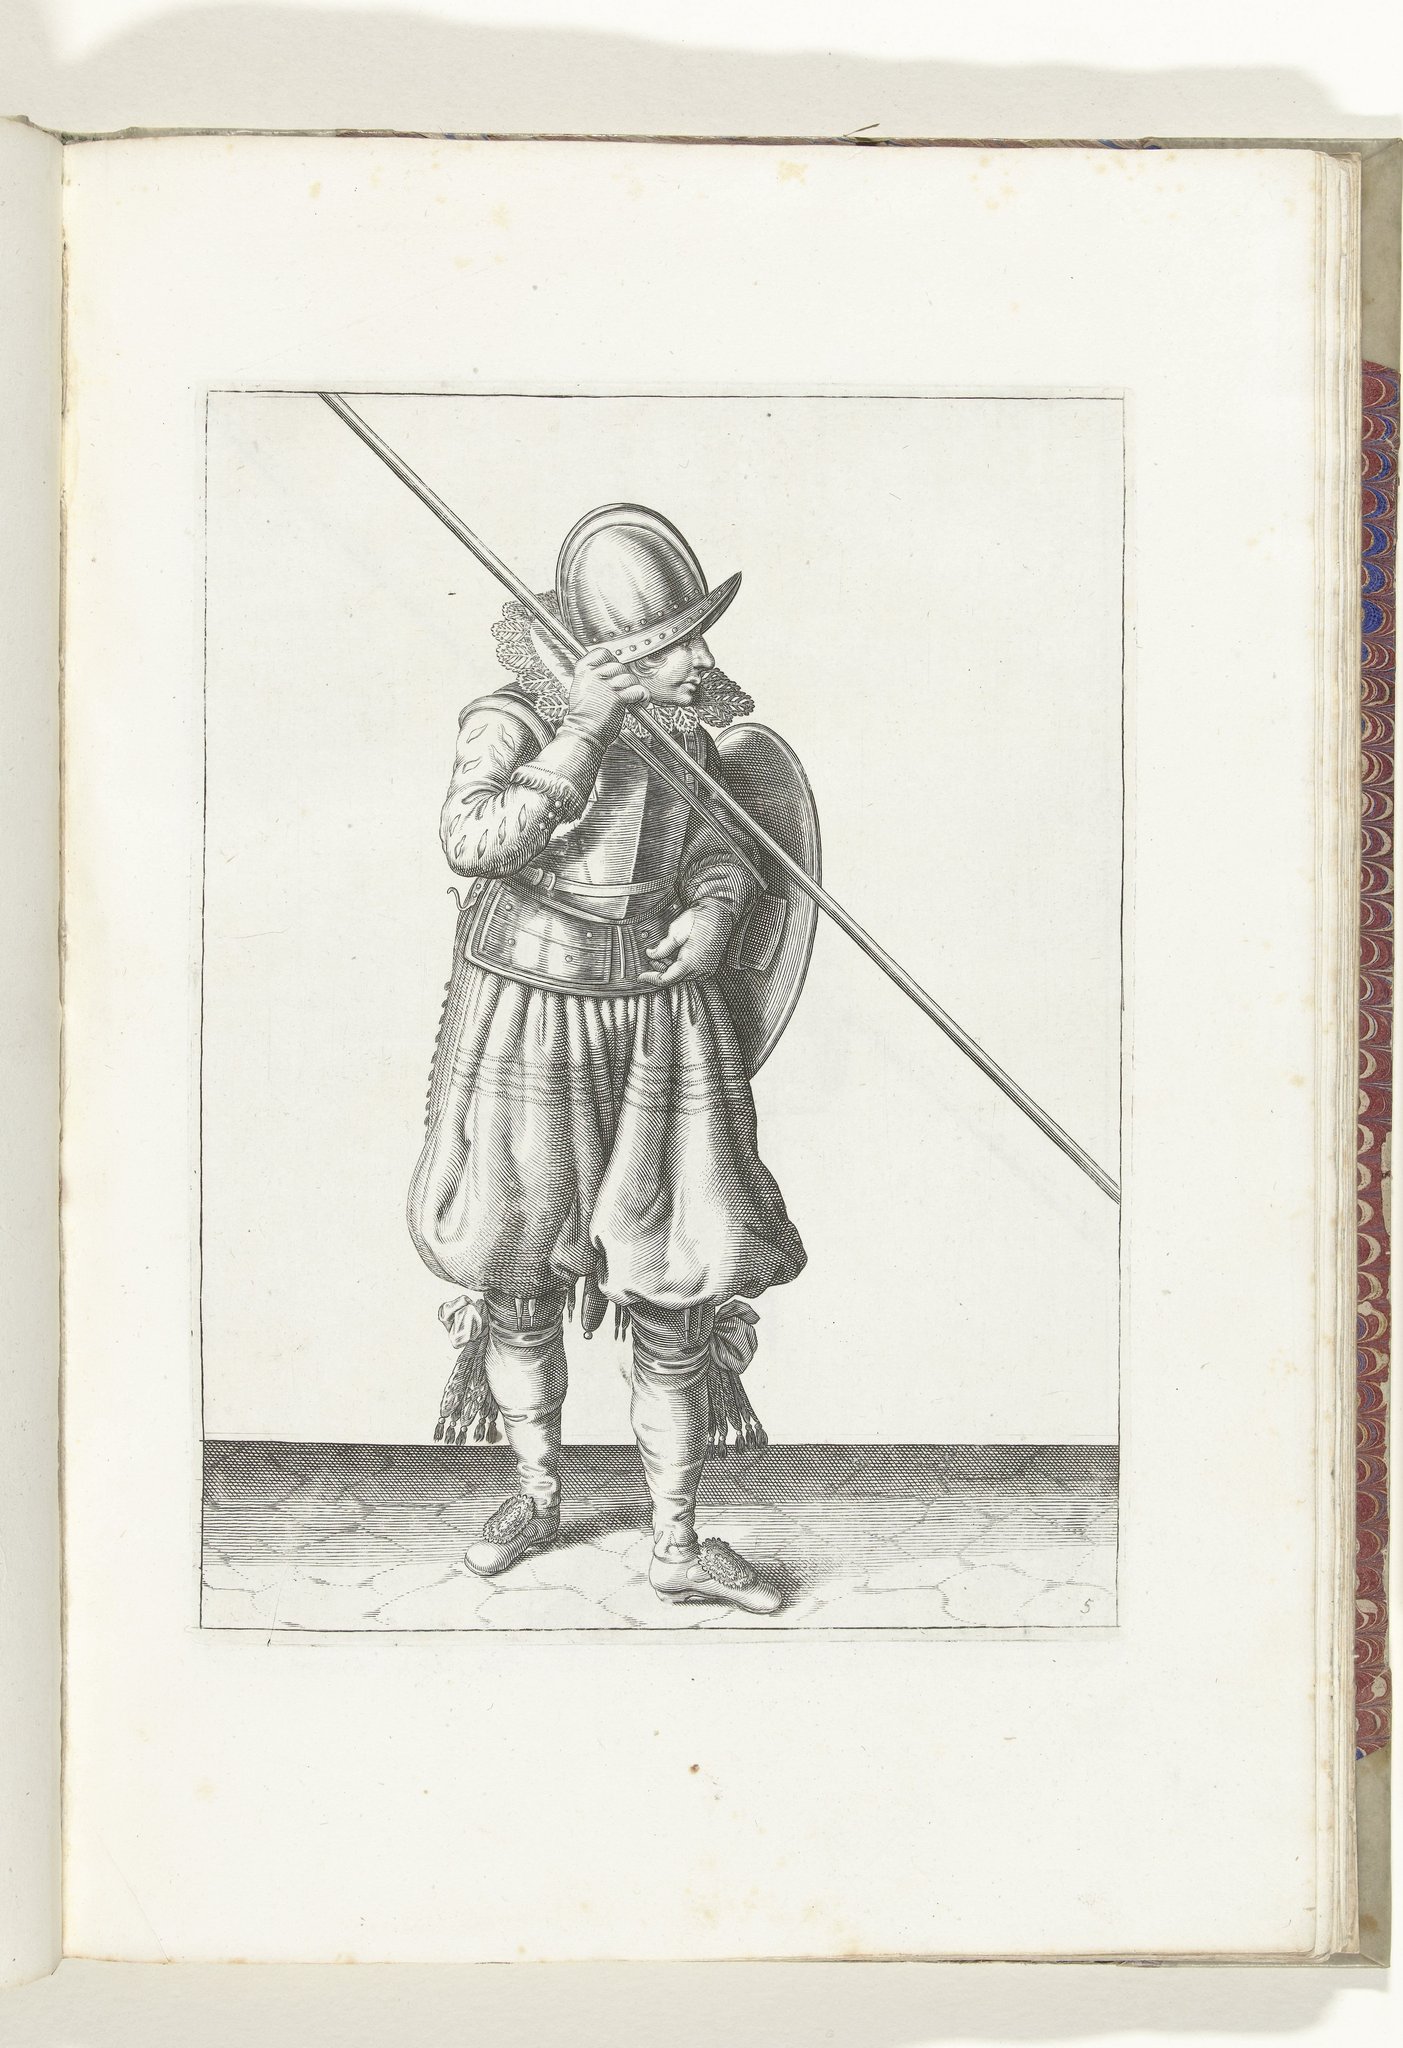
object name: print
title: De Nassausche Wapen-Handelinge, van Schilt, Spies, Rappier ende Targe : beyde figuerlick afgebeelt, ende gestelt na de nieu ordening [van] (...) Maurits van Nassau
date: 1616-1618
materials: paper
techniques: engraving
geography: the hague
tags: maurice (prince of orange), handling of weapons ~ military training, weapons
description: Illustratie in: Adam van Breen, De Nassausche Wapen-Handelinge, van Schilt, Spies, Rappier ende Targe : beyde figuerlick afgebeelt, ende gestelt na de nieu ordening [van] ... Maurits van Nassau, 's-Gravenhage, [Aert Meuris] 1618, plaat nr. 5. In het exemplaar in de collectie van de Rijksmuseum Research Library (326 F 22).